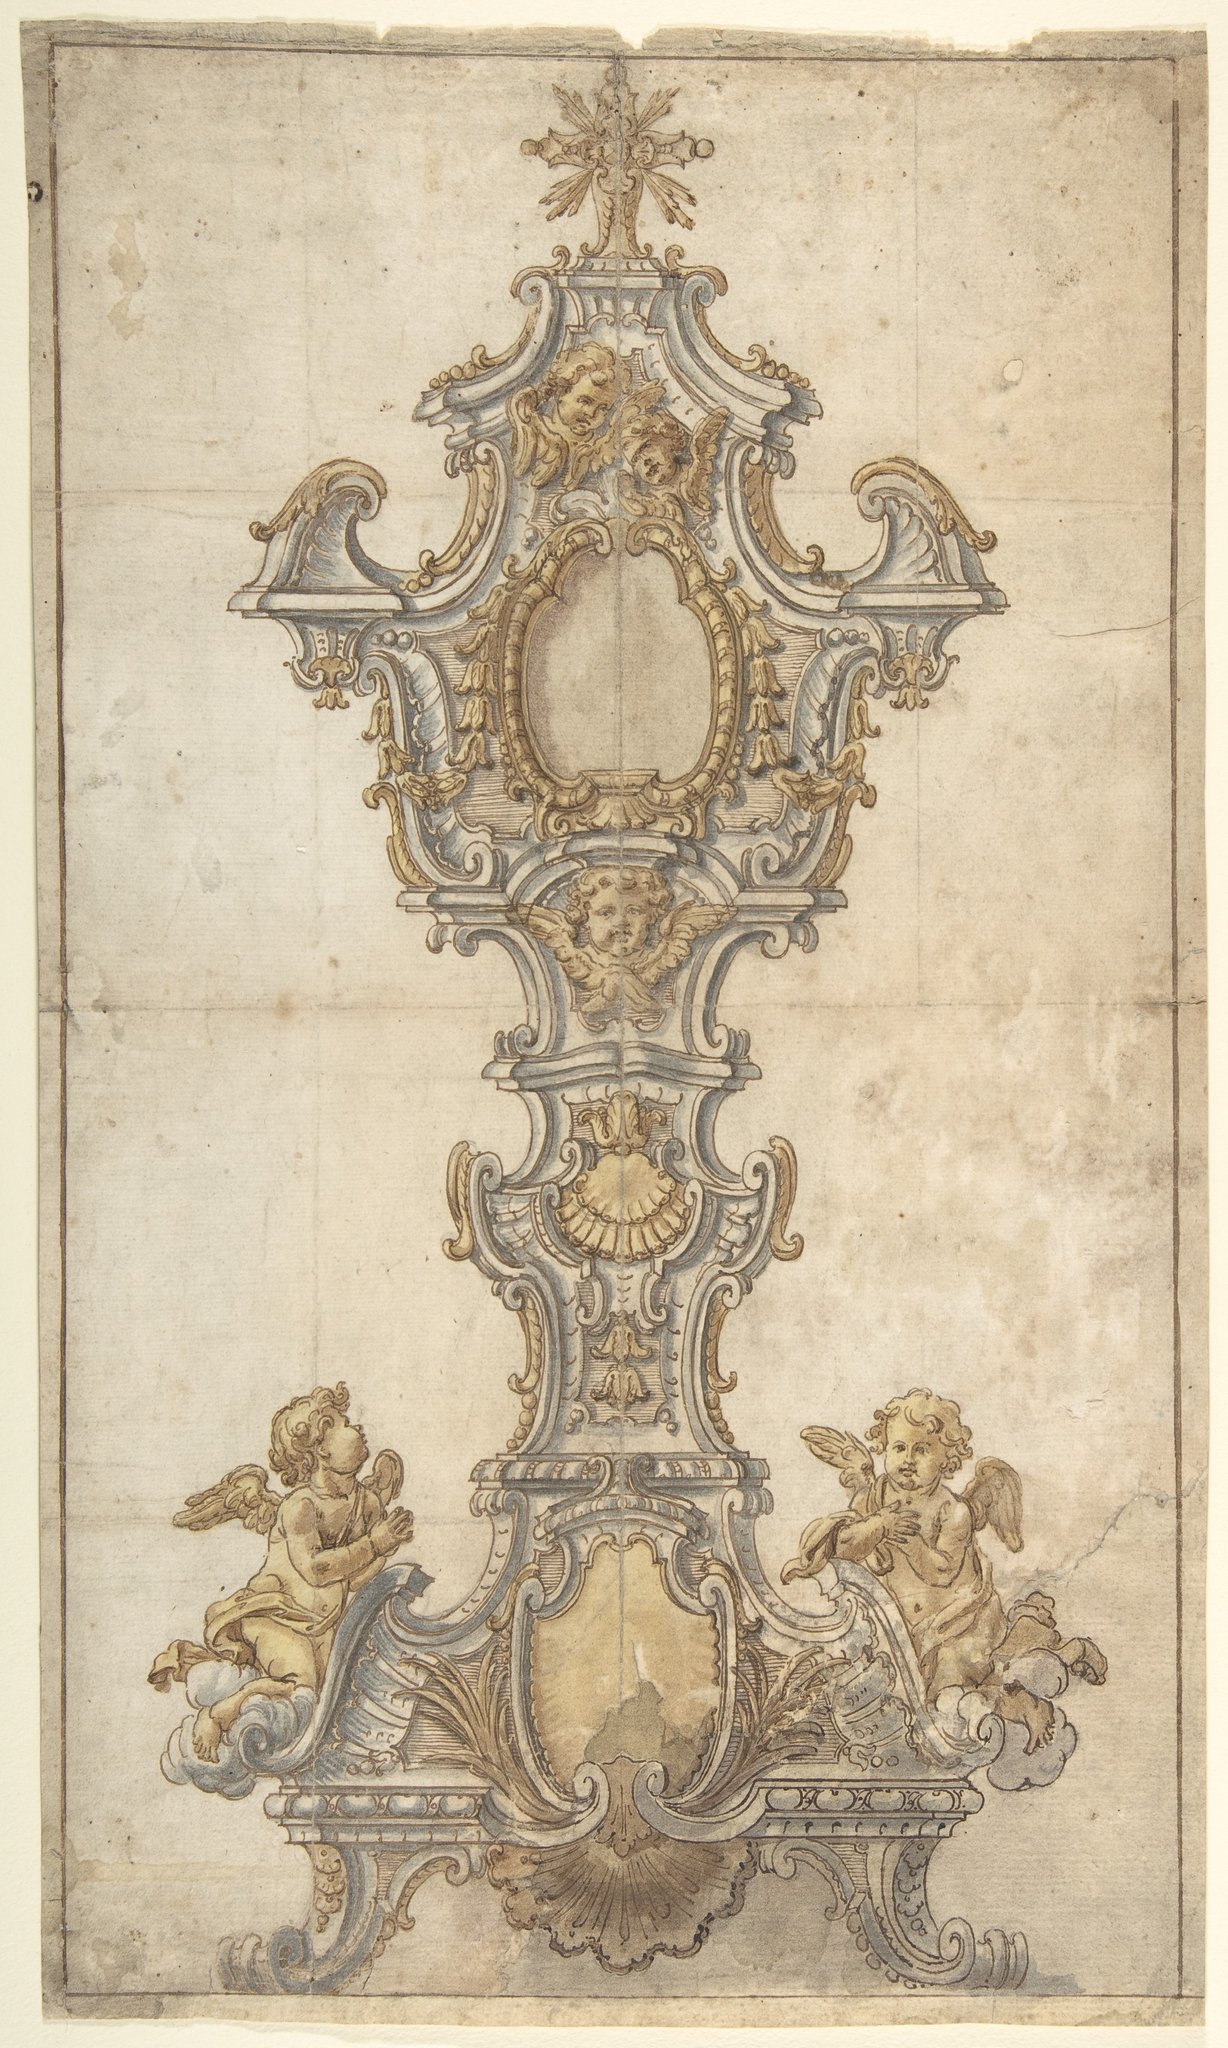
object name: drawing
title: Monstrance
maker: anonymous, italian, 18th century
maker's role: artist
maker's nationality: italian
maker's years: 1700-1800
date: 1701-1800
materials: ink, paper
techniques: brush, pen, wash